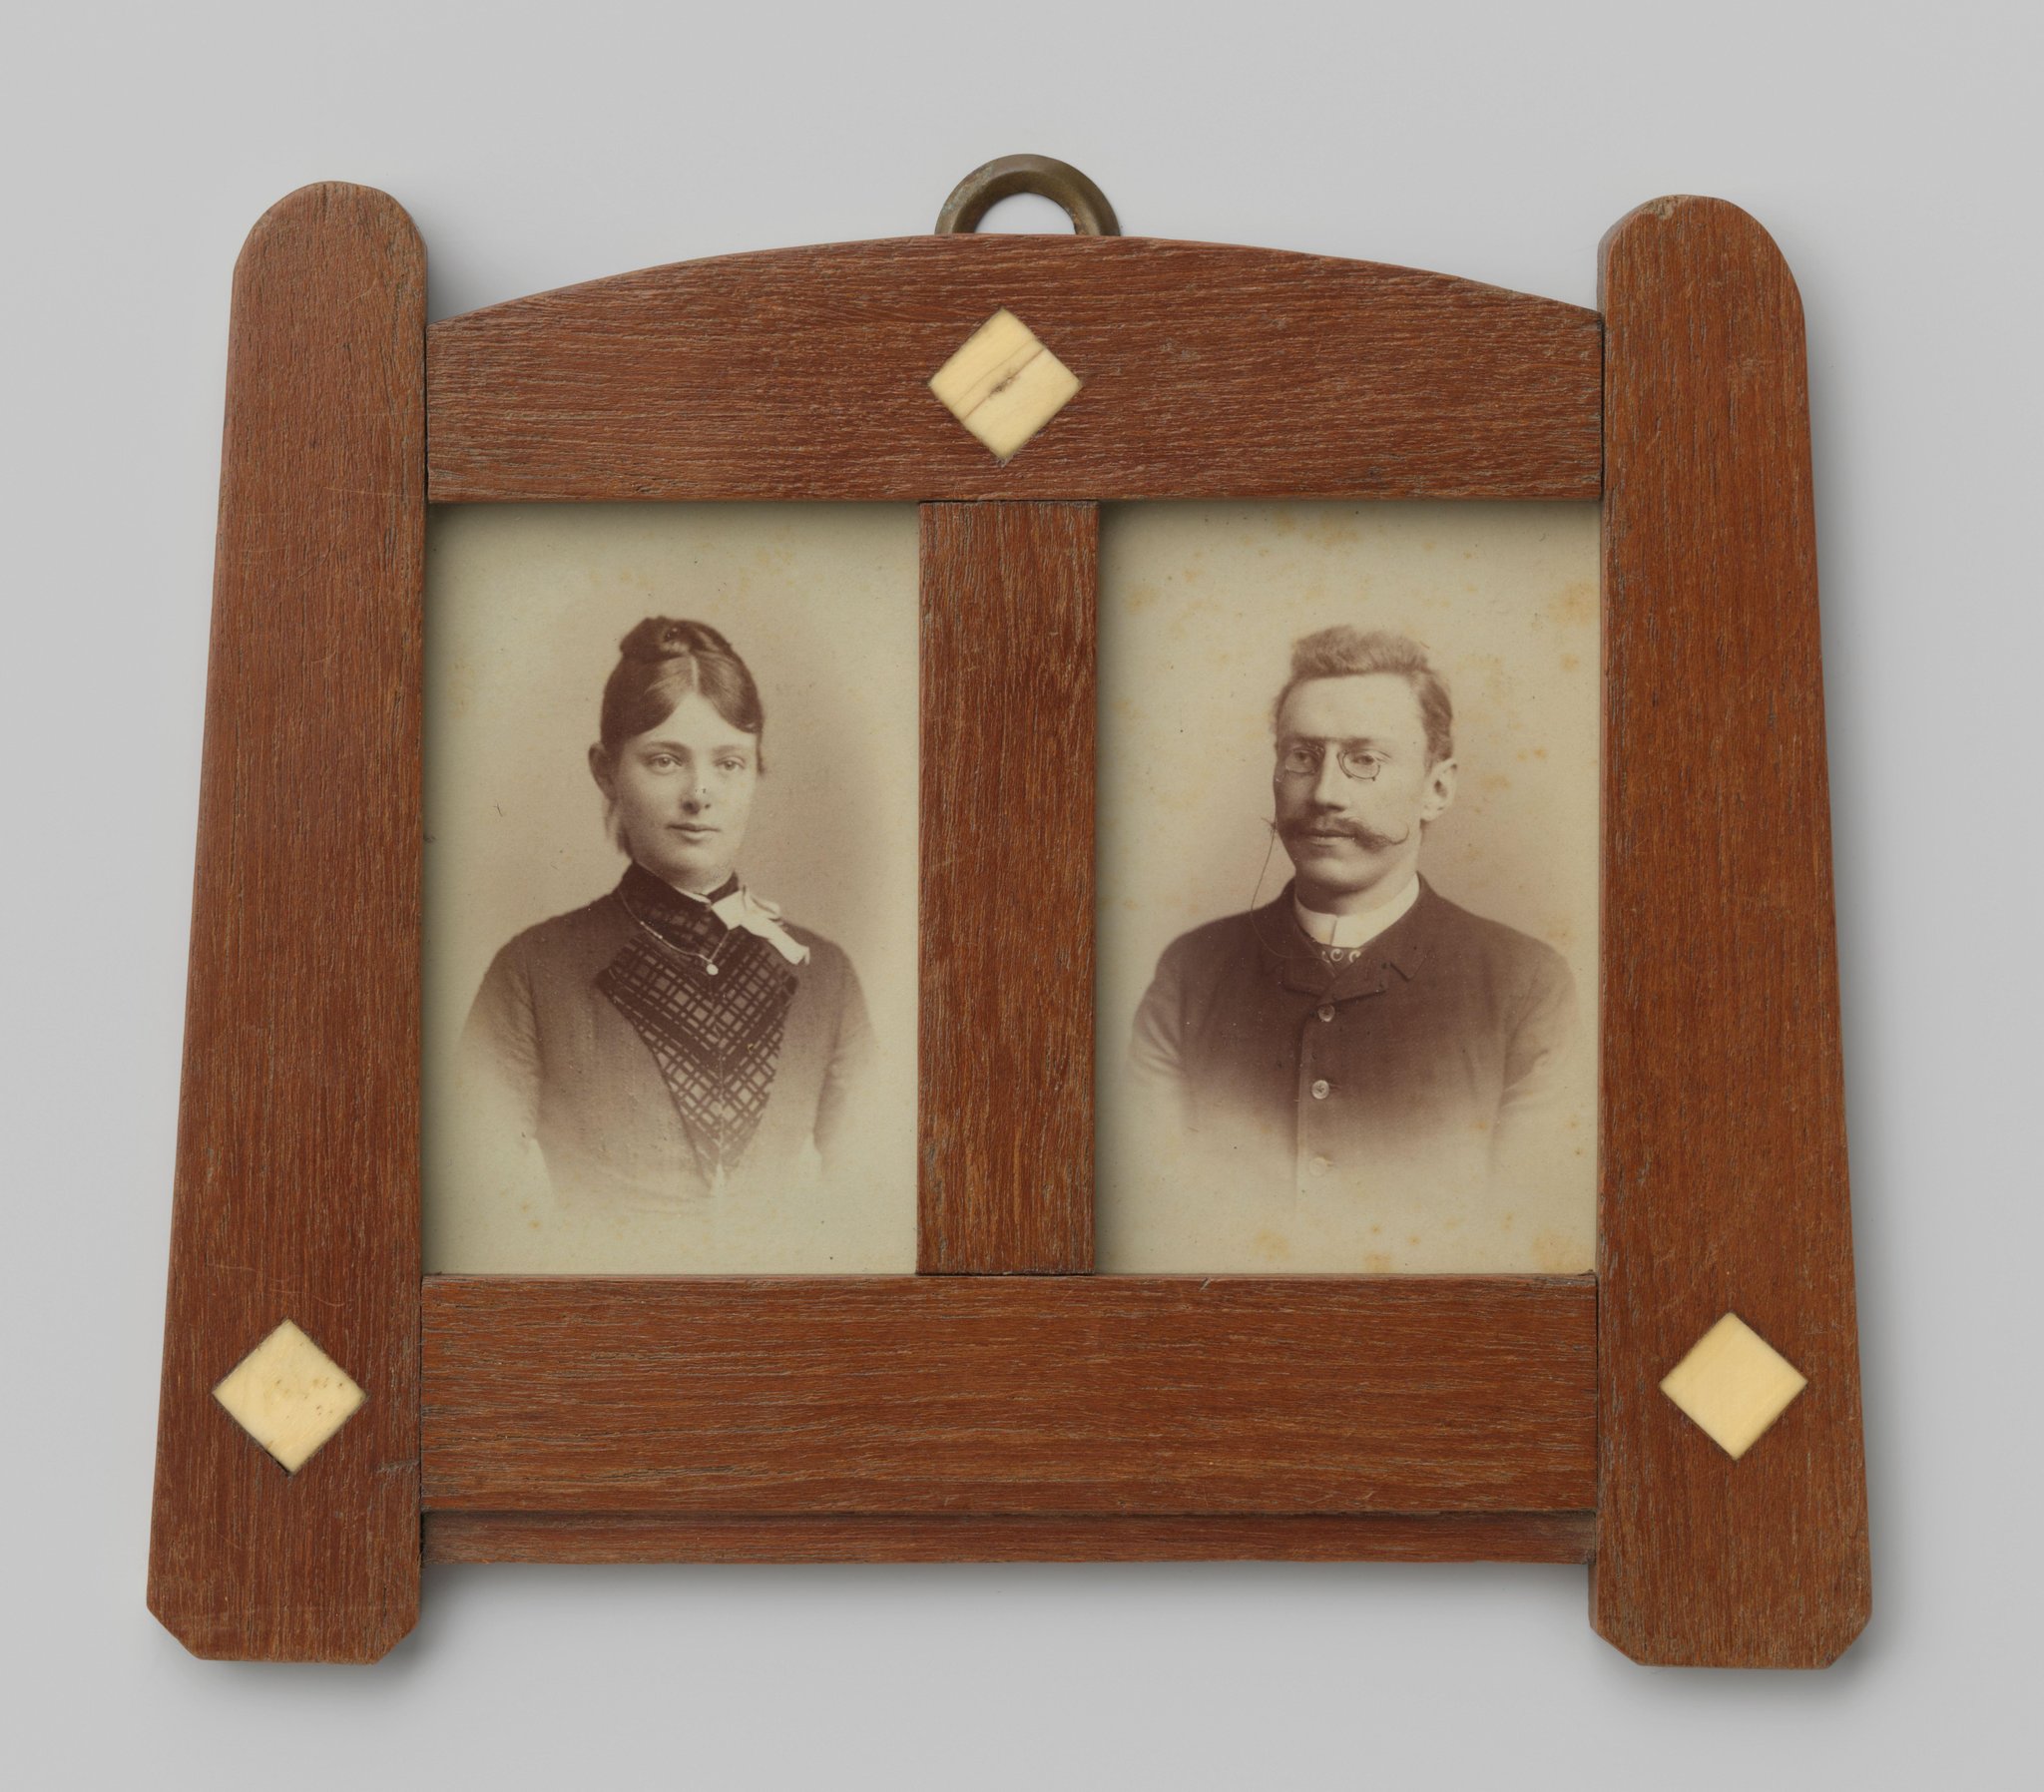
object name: frame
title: Twee portretten van een onbekende man en een onbekende vrouw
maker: Anonymous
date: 1880-1900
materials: cardboard, glass, metal, paper, wood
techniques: albumen print, inlay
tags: adult man, anonymous historical person portrayed, anonymous historical person portrayed - bb - woman